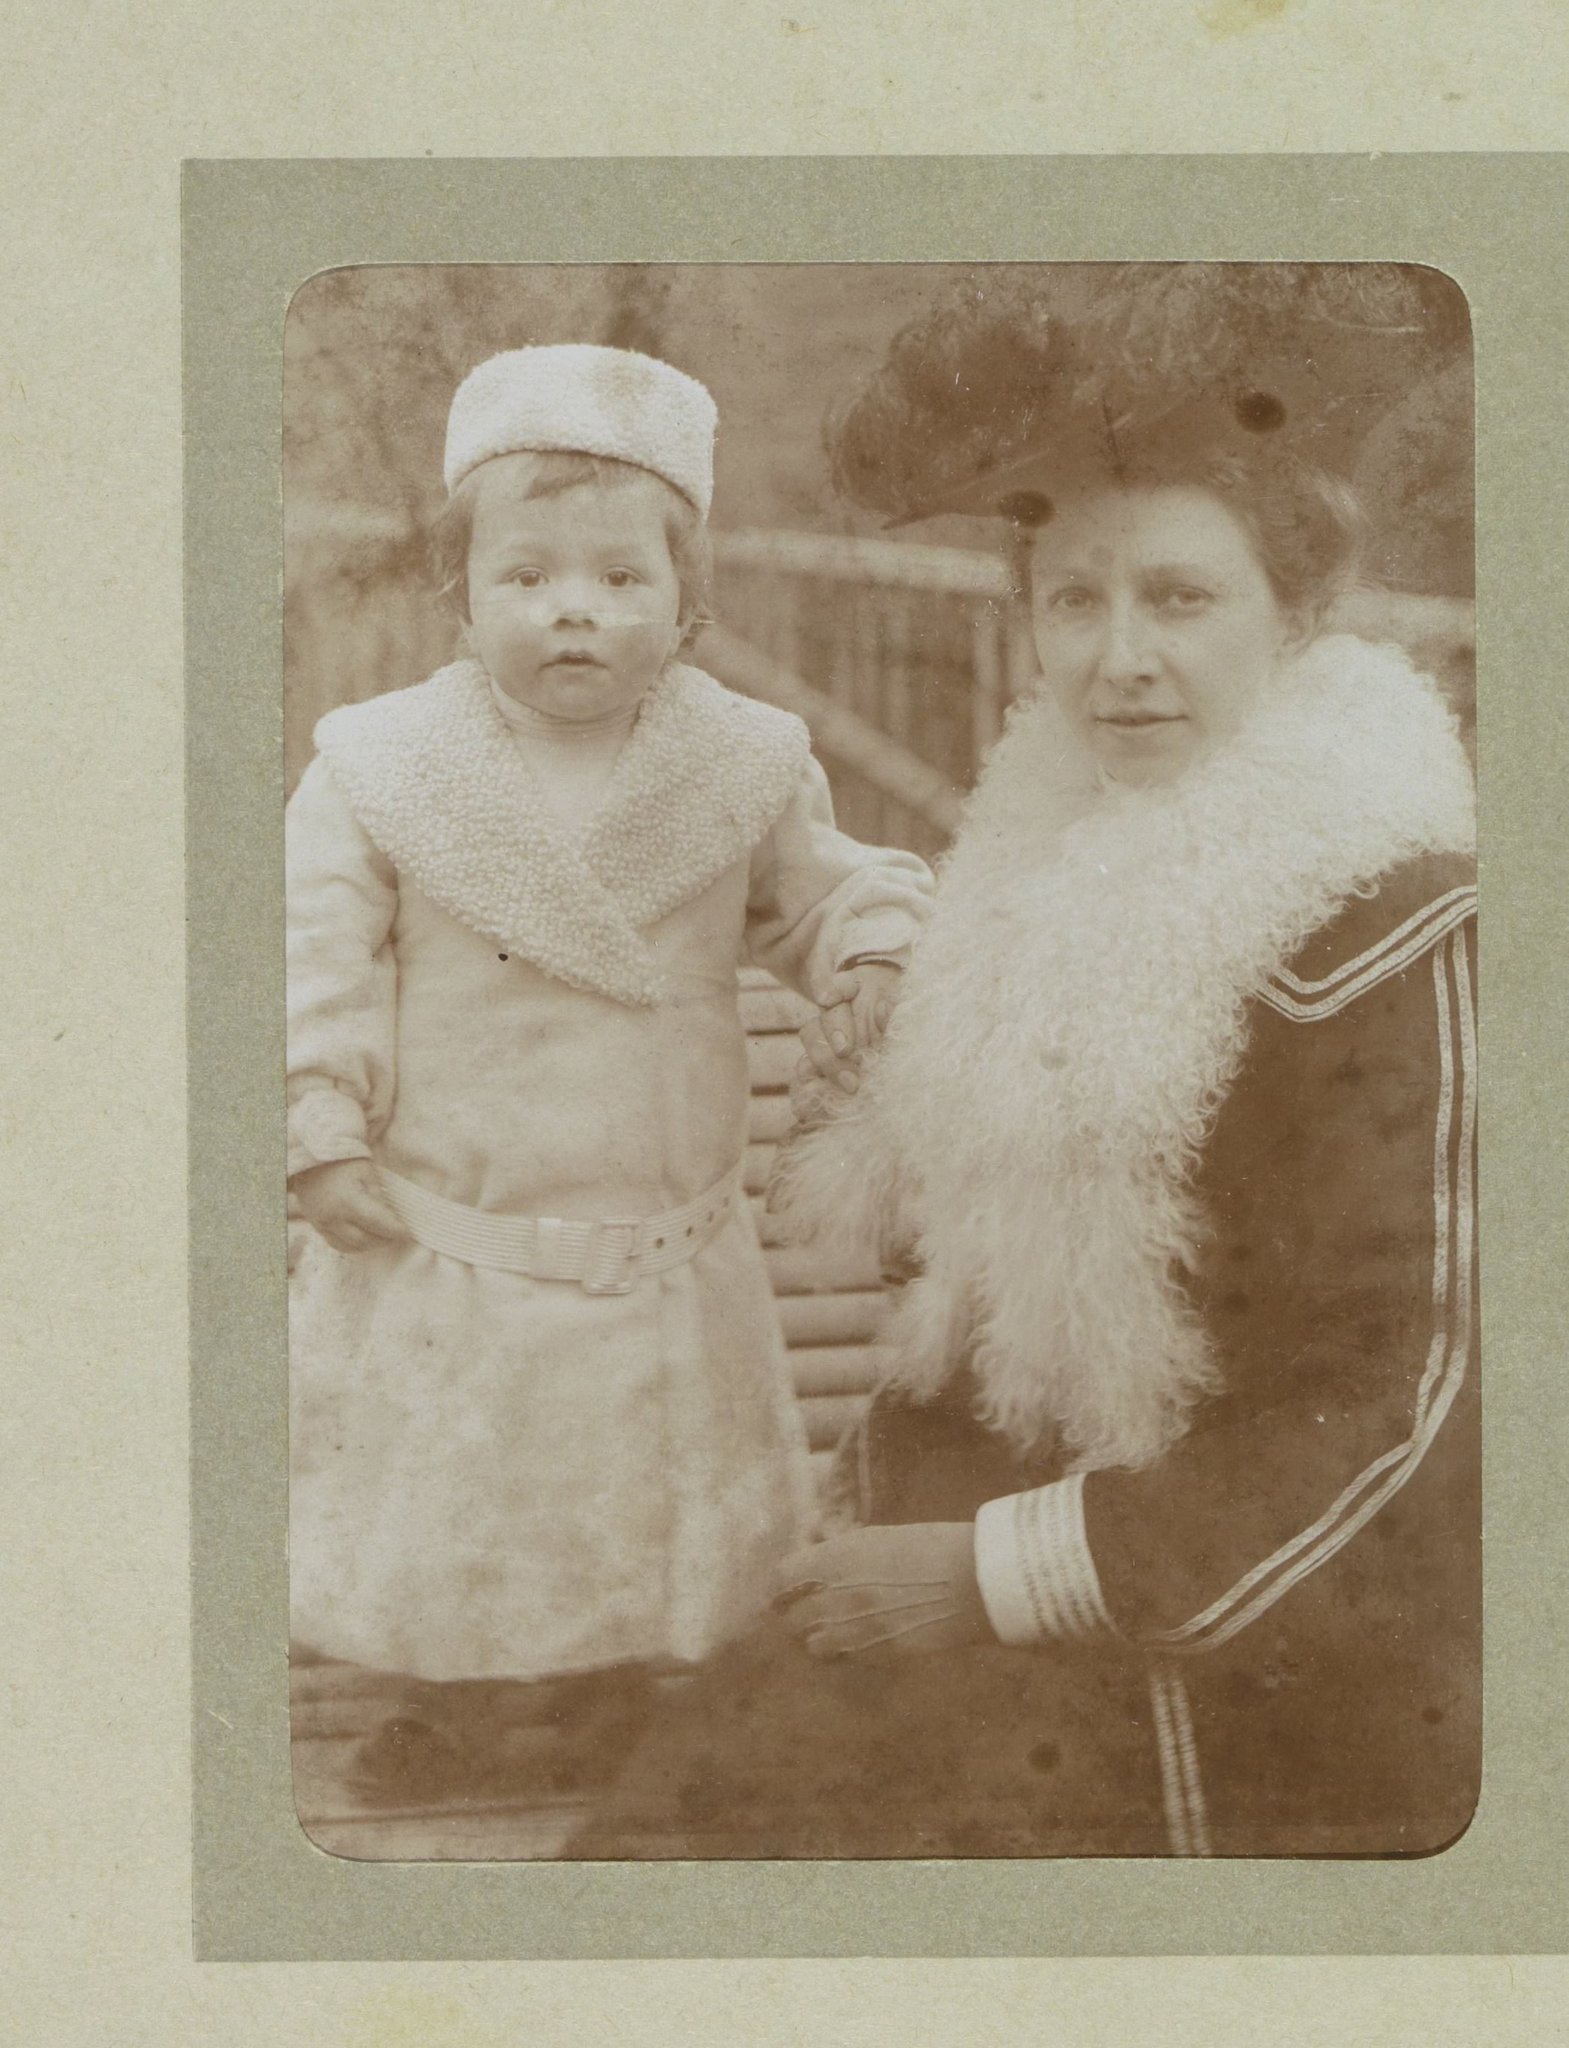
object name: photograph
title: Portret van een vrouw met bontsjaal en hoed met kind in mantel met bontkraag en hoed, waarschijnlijk Han van der Kop en zijn moeder W.G. Hoogendijk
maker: willem carel van der kop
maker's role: amateurfotograaf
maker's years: 1869-1924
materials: cardboard, paper, photographic support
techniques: collodion silver print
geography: schoonhoven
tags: coat (+ fur used for clothes), neck-gear ~ clothing, head-gear: hat, family life, mother and baby or young child, infant, baby, brothers or sisters (second degree family relationships)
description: Onderdeel van Fotoalbum met opnames van Ad, Johanna en Han van der Kop, hun moeder W.G. Hoogendijk en familieleden.